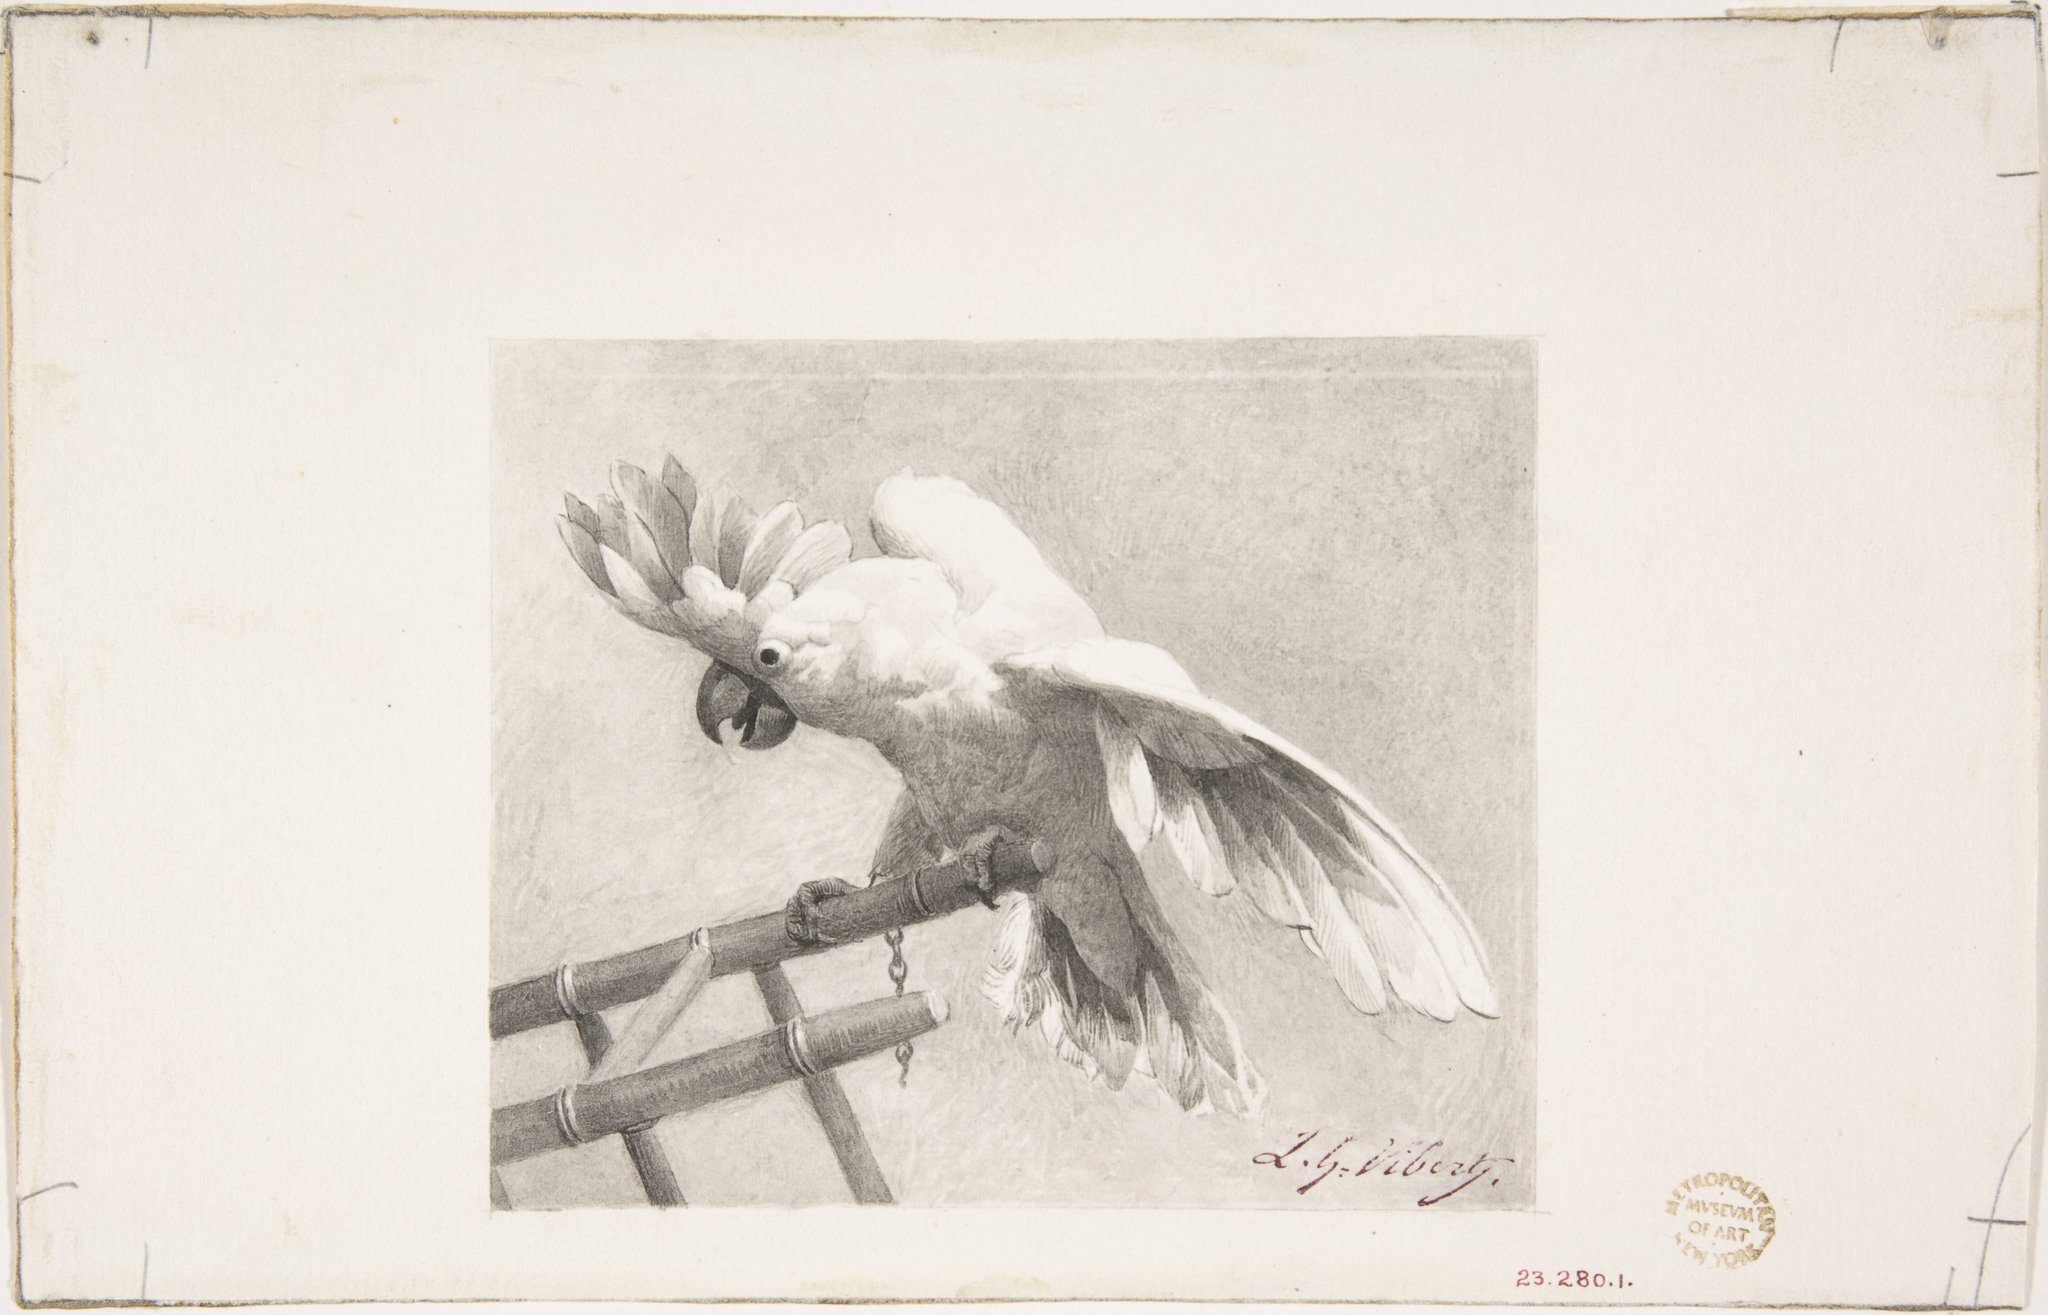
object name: drawing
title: The Angry Parrot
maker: jean-georges vibert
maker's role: artist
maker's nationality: french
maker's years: 1840-1902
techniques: wash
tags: parrots